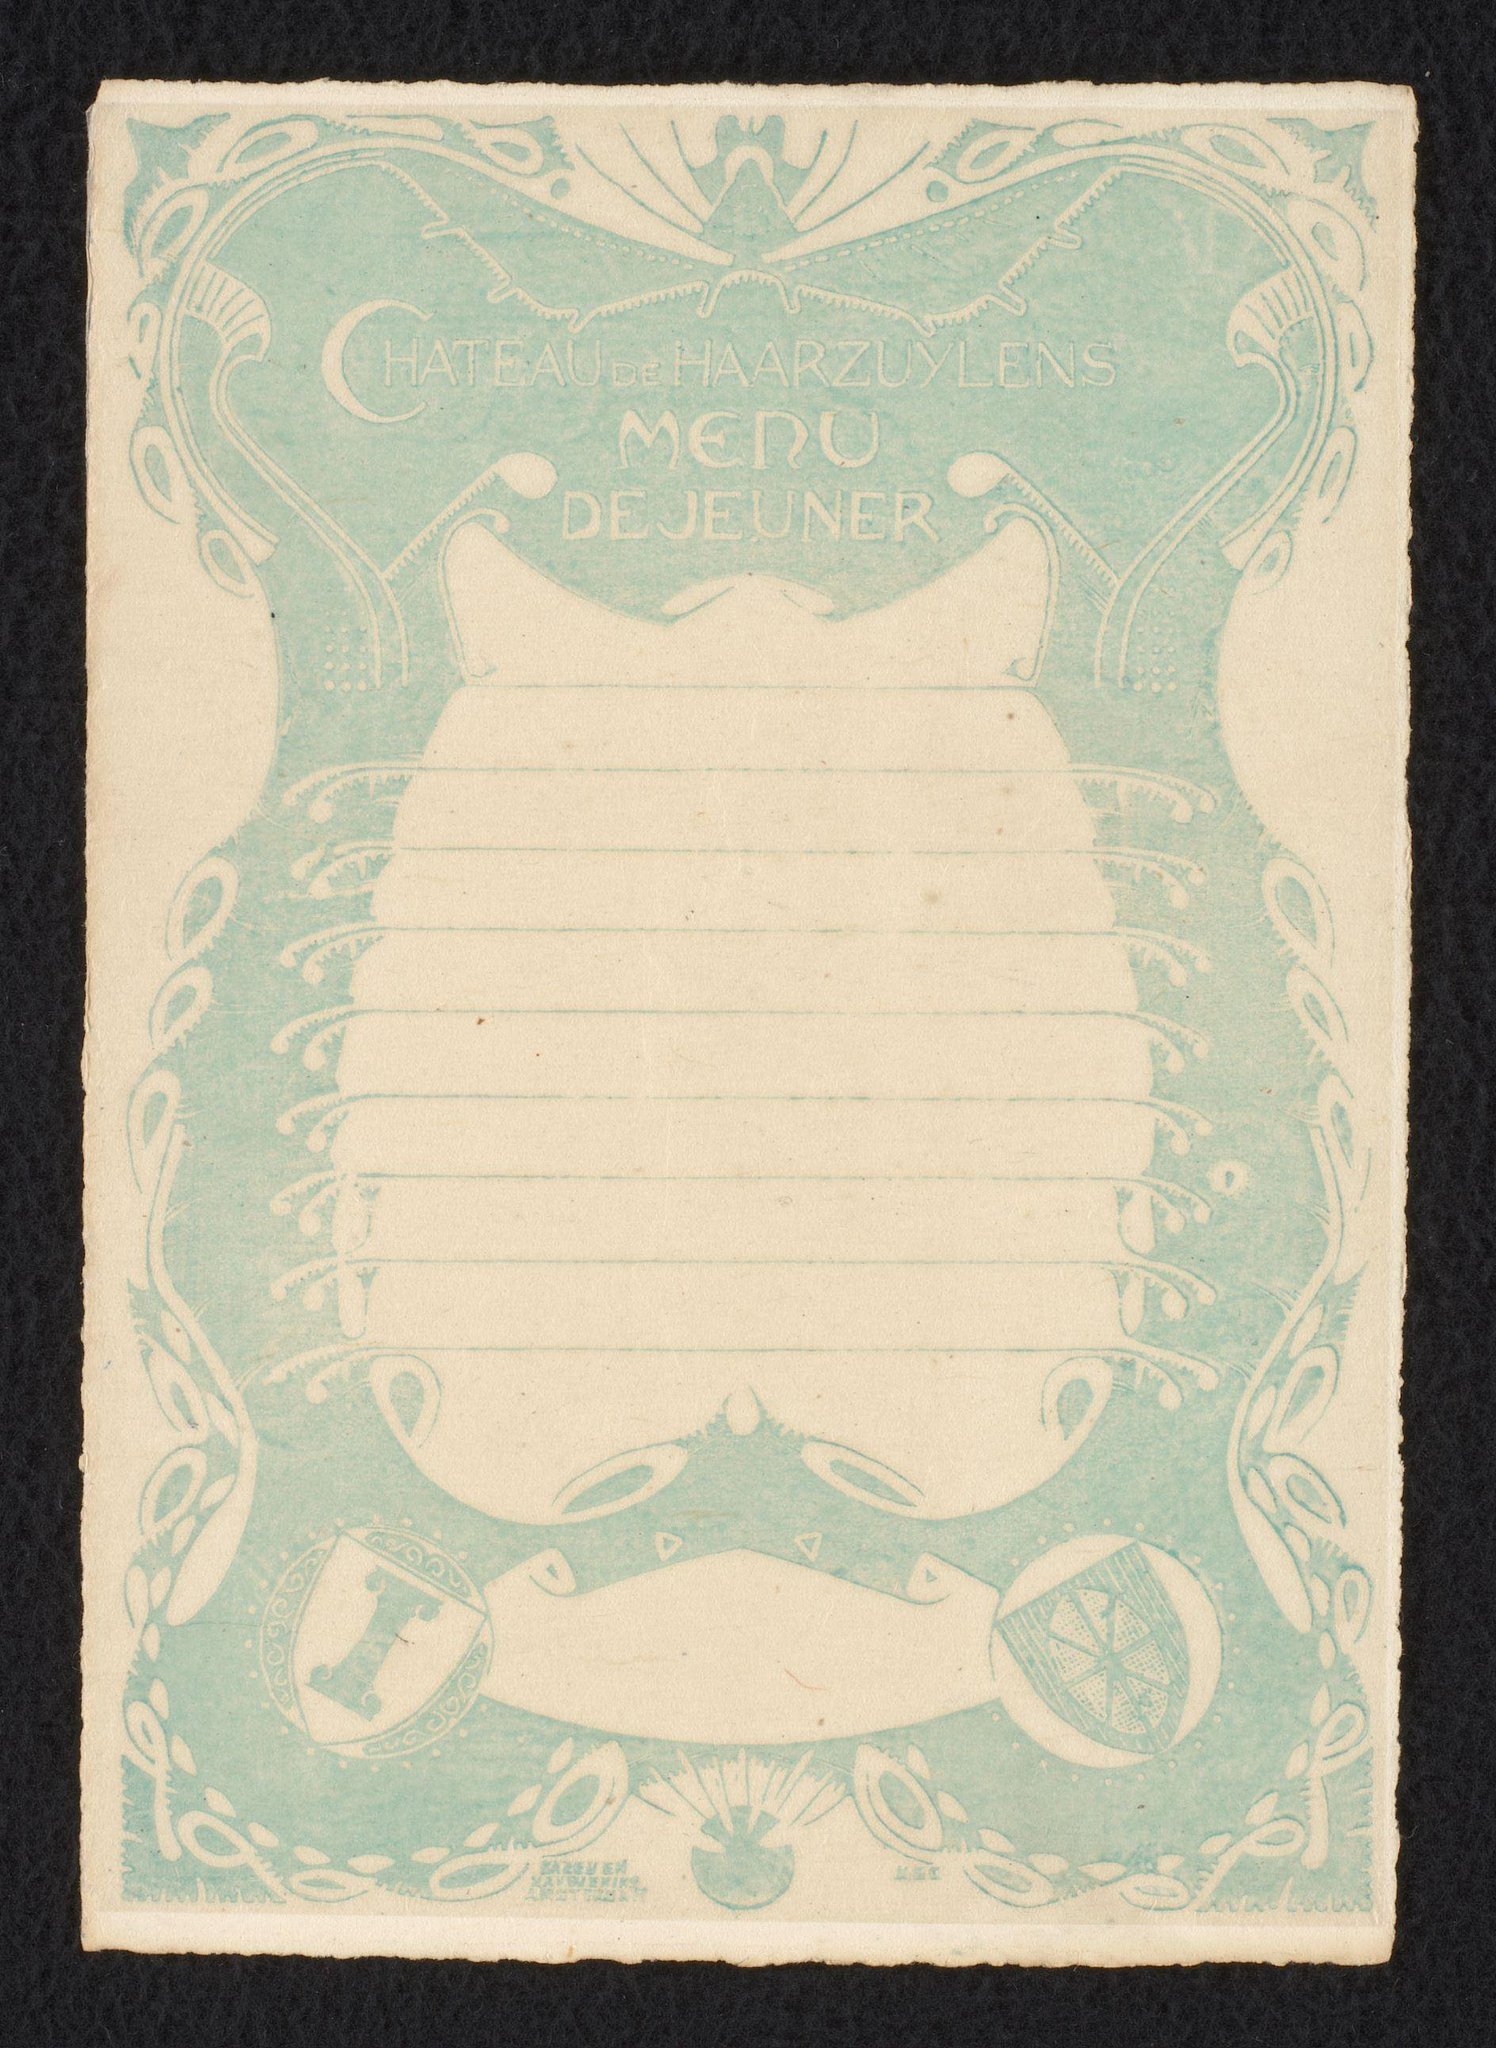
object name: menu, menukaart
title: Menukaart Château de Haarzuylens déjeuner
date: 1896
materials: paper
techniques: woodcut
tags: ornaments ~ art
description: Menukaart voor kasteel De Haar in Haarzuilens.